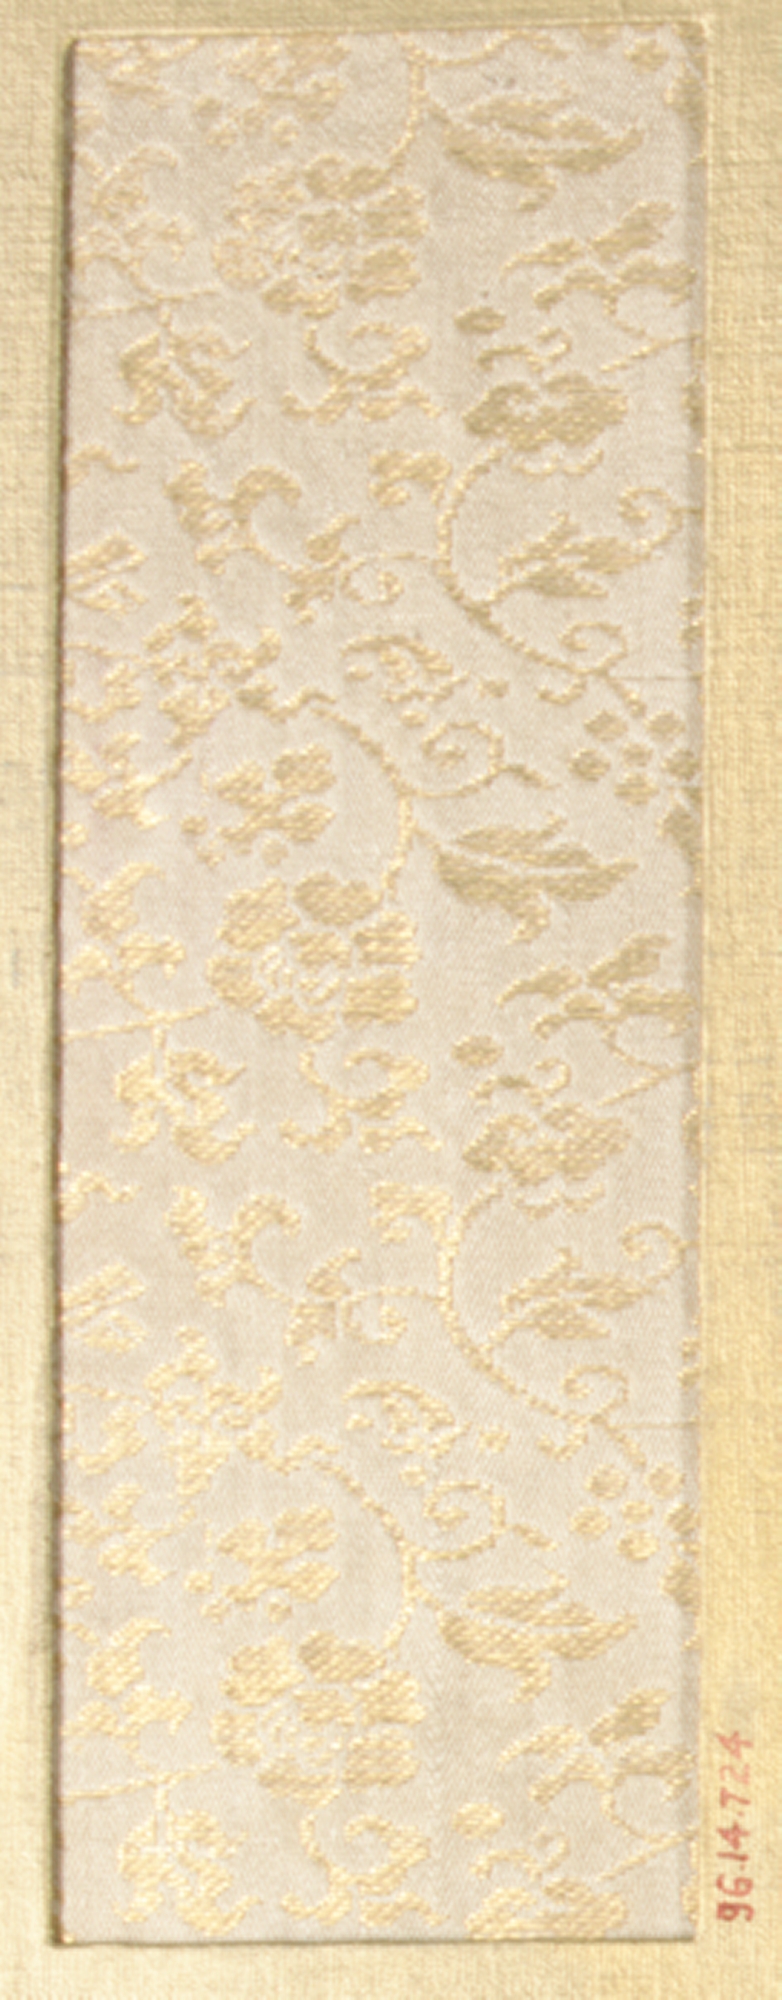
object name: piece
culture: japanese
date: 1701-1900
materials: silk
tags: leaves